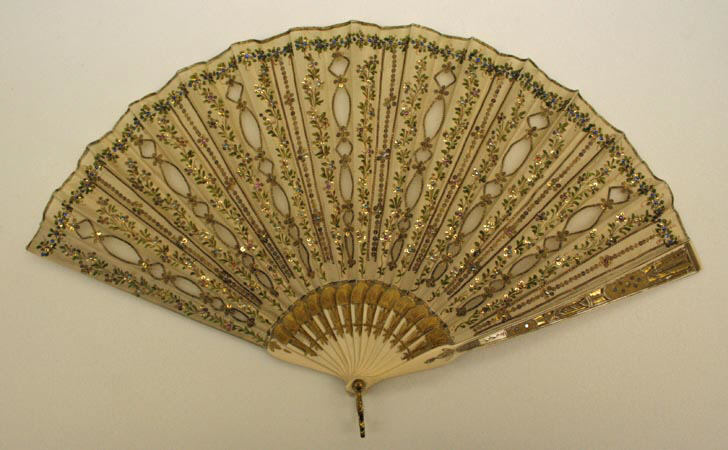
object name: fan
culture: french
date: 1701-1800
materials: ivory, silk